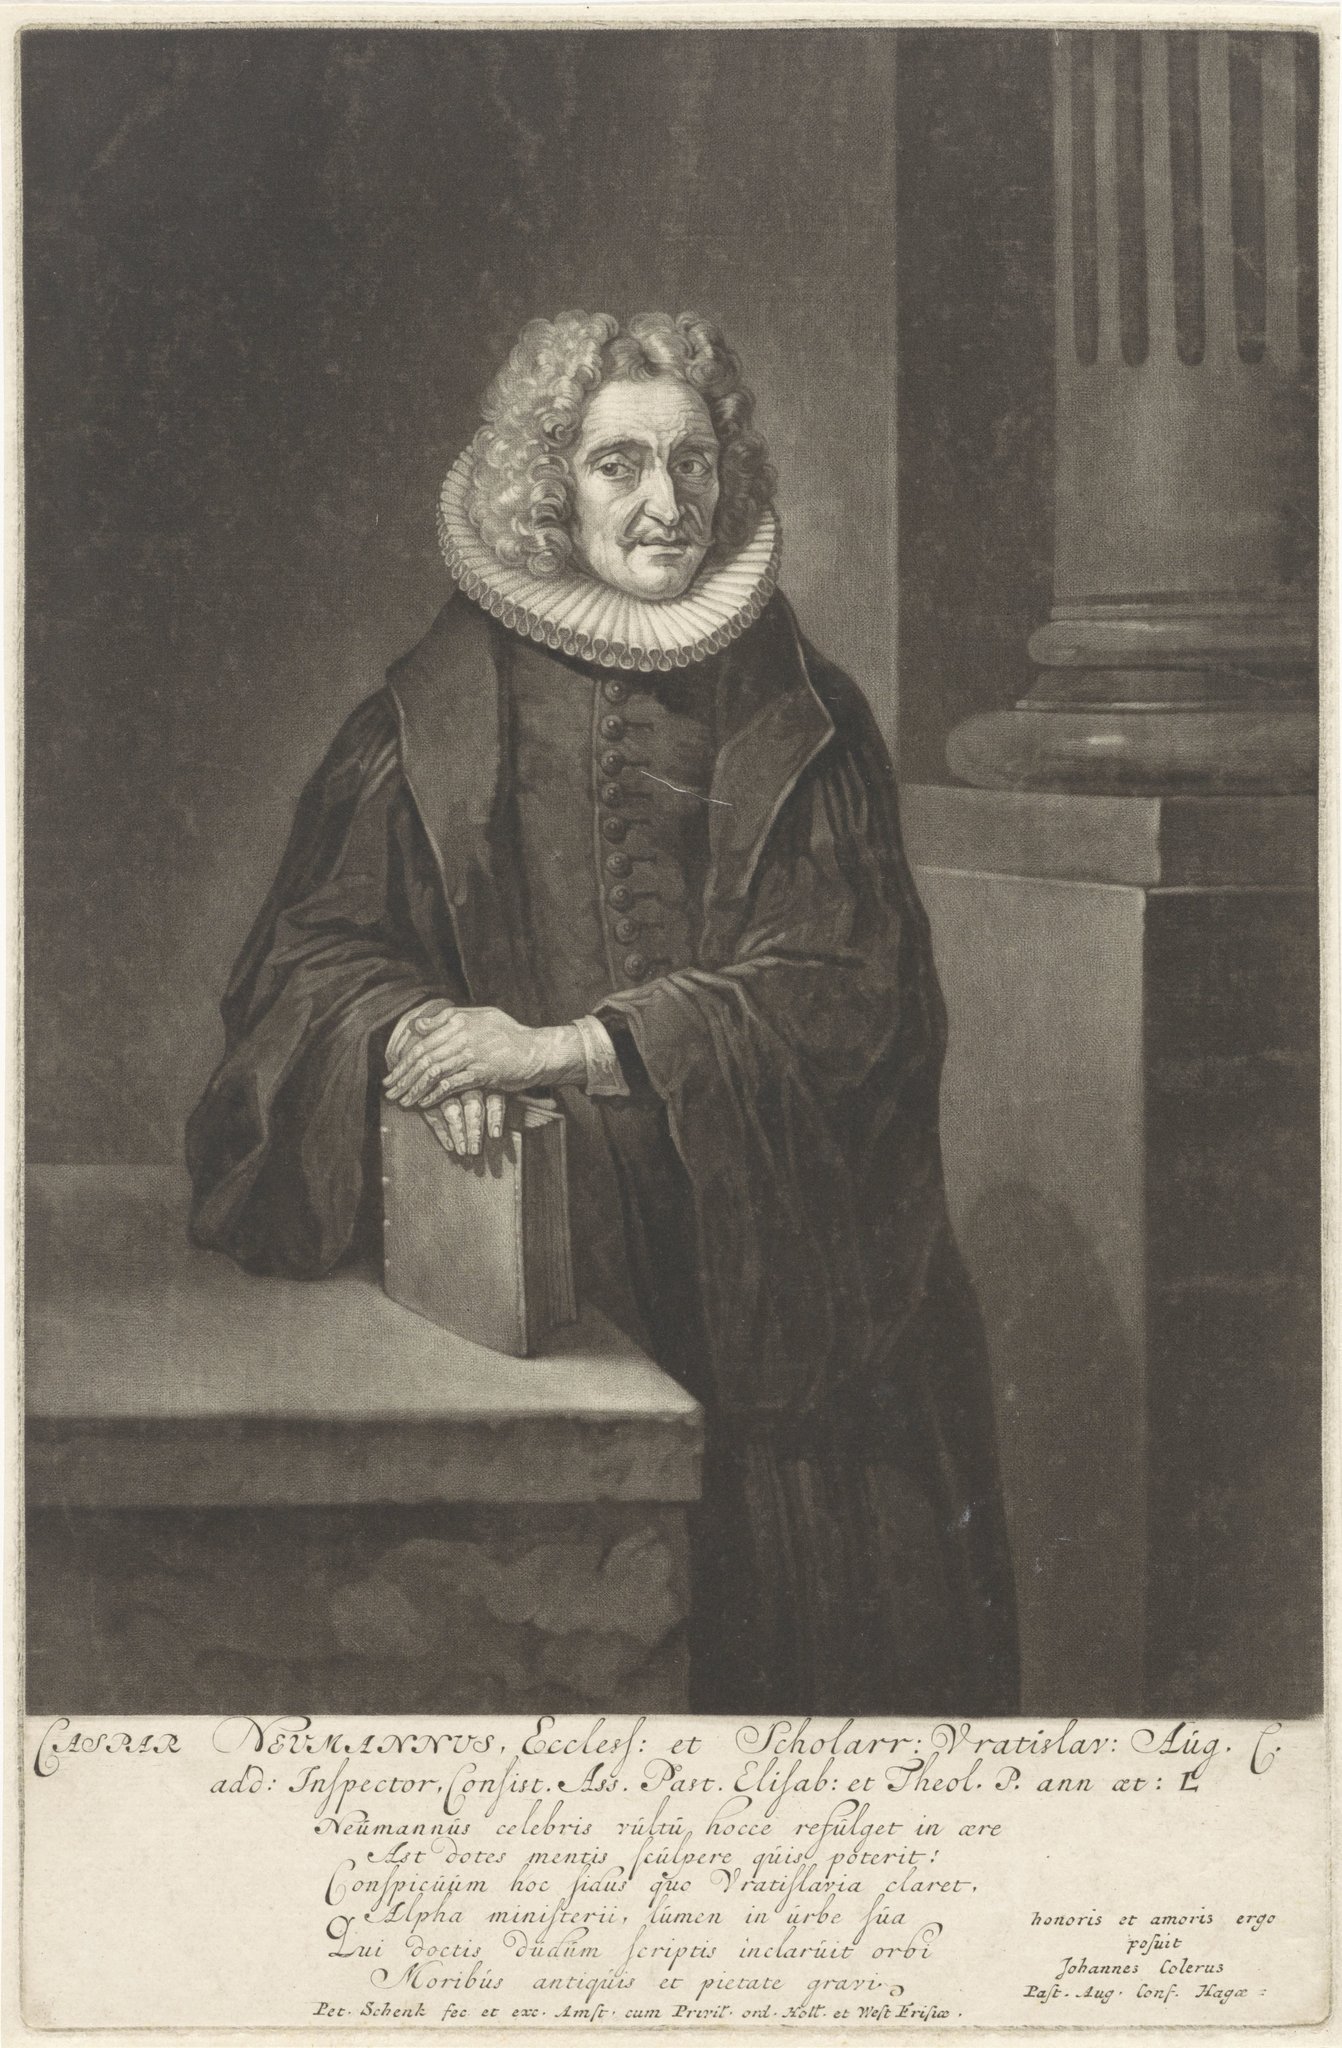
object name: print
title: Portret van Kaspar Neumann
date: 1670-1713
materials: paper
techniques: engraving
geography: amsterdam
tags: theologian, book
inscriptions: collector's mark: Lugt 2228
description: De theoloog en dichter Kaspar Neumann staat naast een zuil. Hij steunt met zijn handen op een boek.